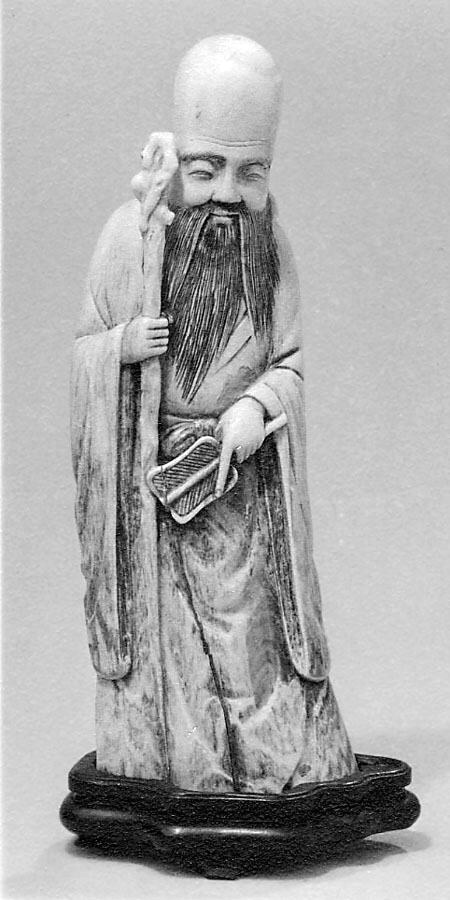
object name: statuette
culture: chinese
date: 1701-1800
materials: ivory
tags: men